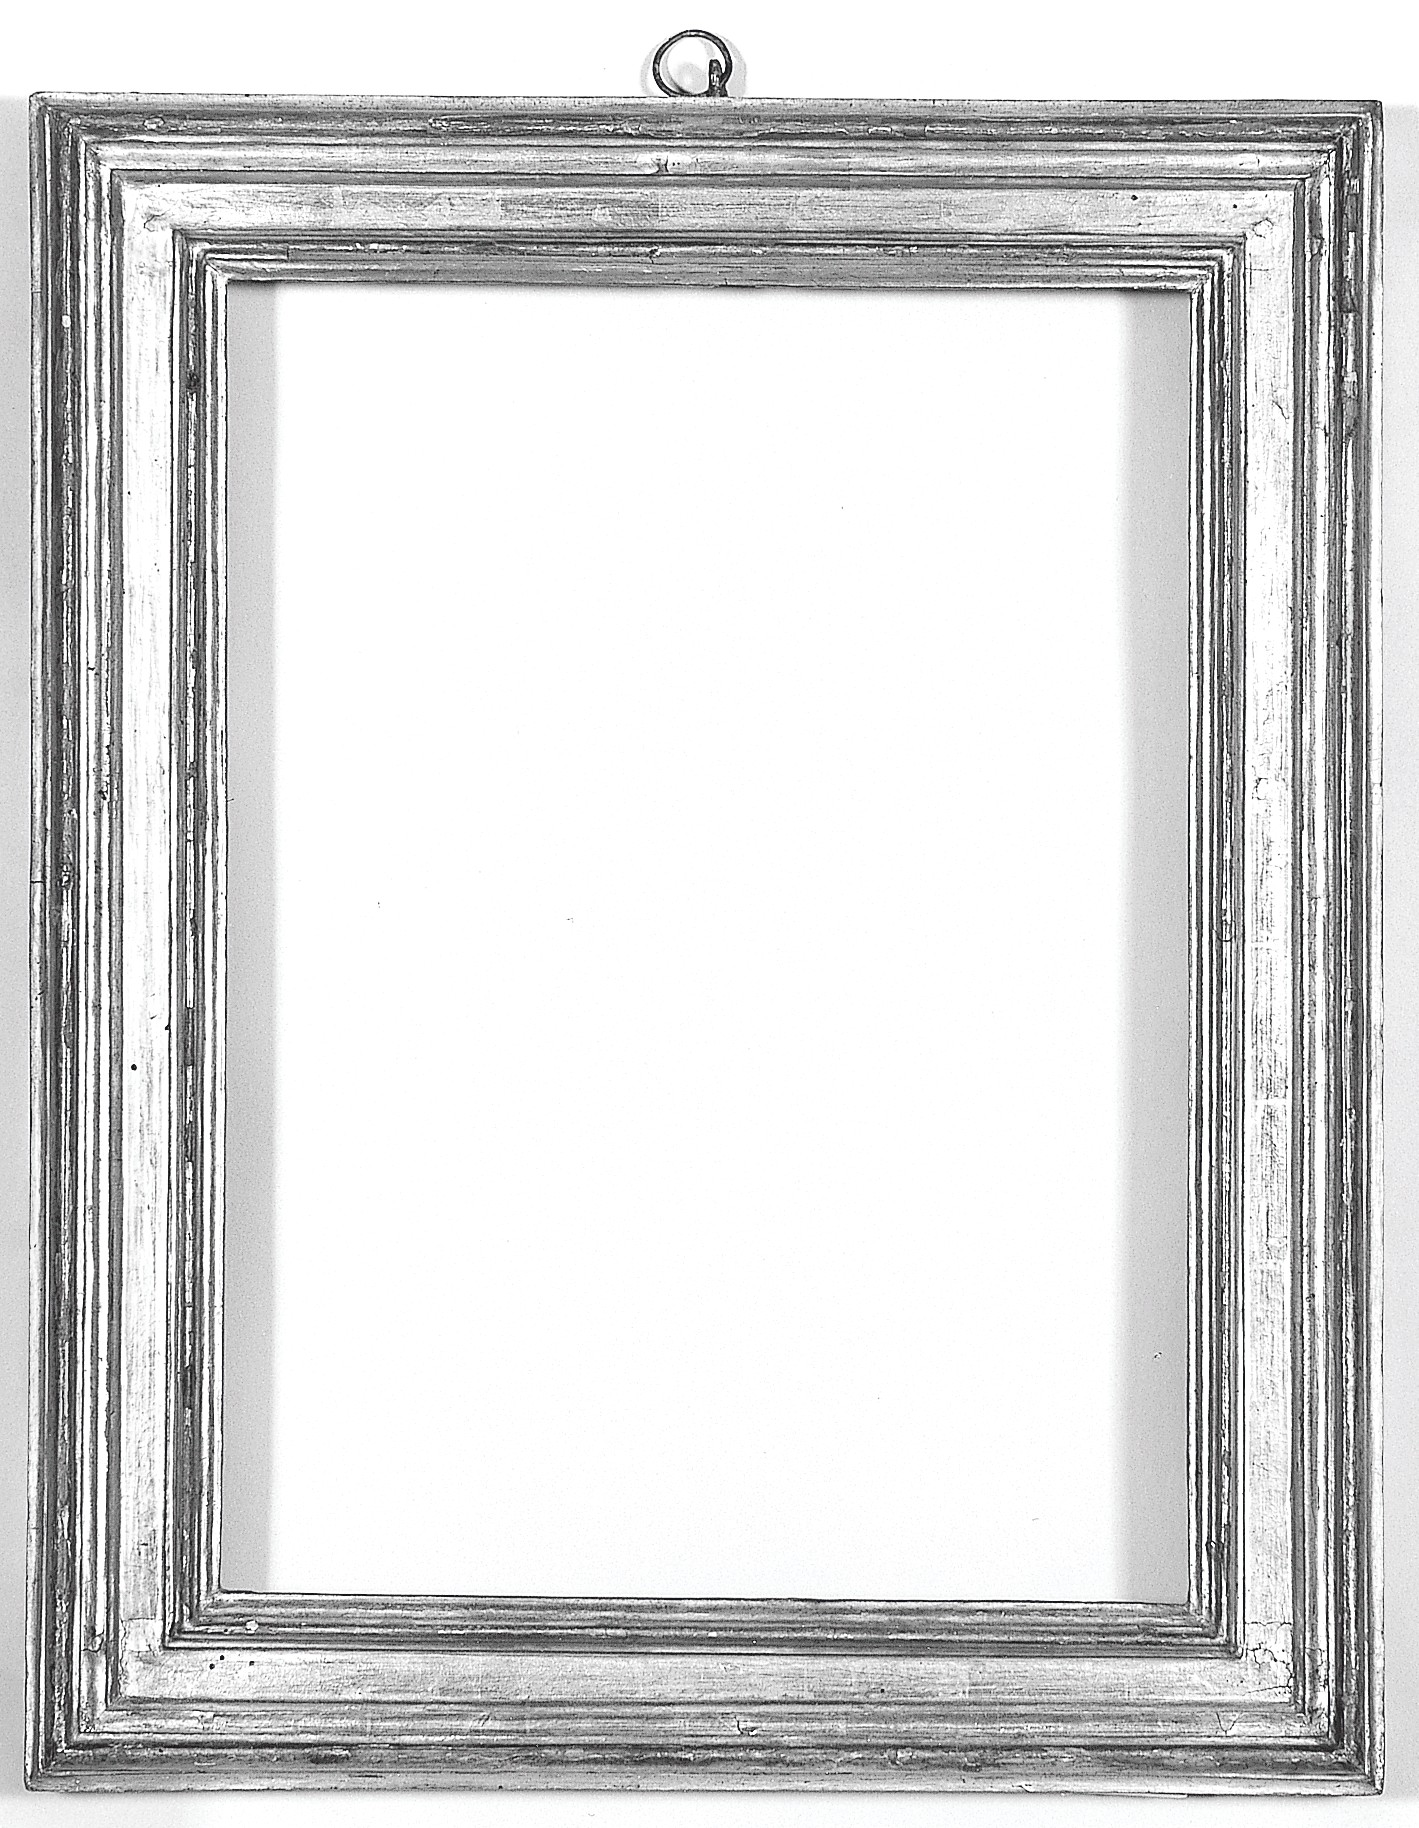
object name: frame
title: Cassetta frame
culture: italian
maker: italy (milan)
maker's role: artist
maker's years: 1610-1650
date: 1630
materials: wood